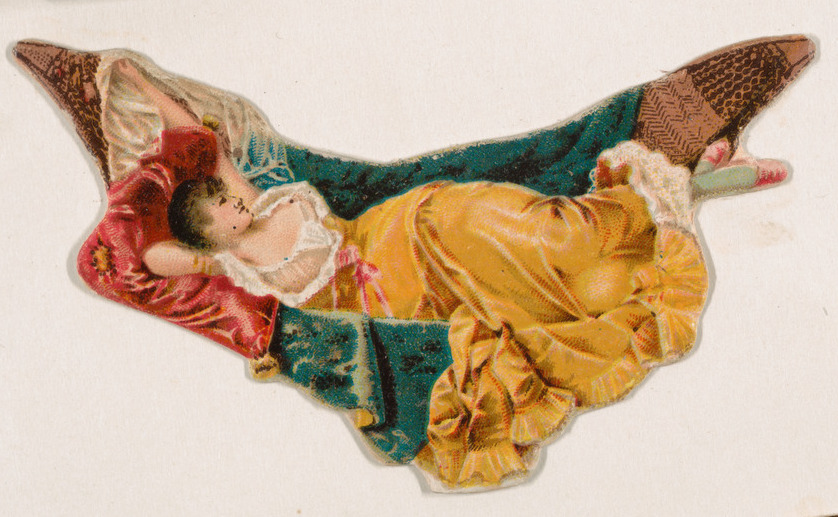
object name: print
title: Hammock, from the Novelties series (N228, Type 3) issued by Kinney Bros.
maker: kinney brothers tobacco company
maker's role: publisher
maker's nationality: american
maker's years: 1869-2011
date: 1889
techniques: color lithograph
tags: profiles,women